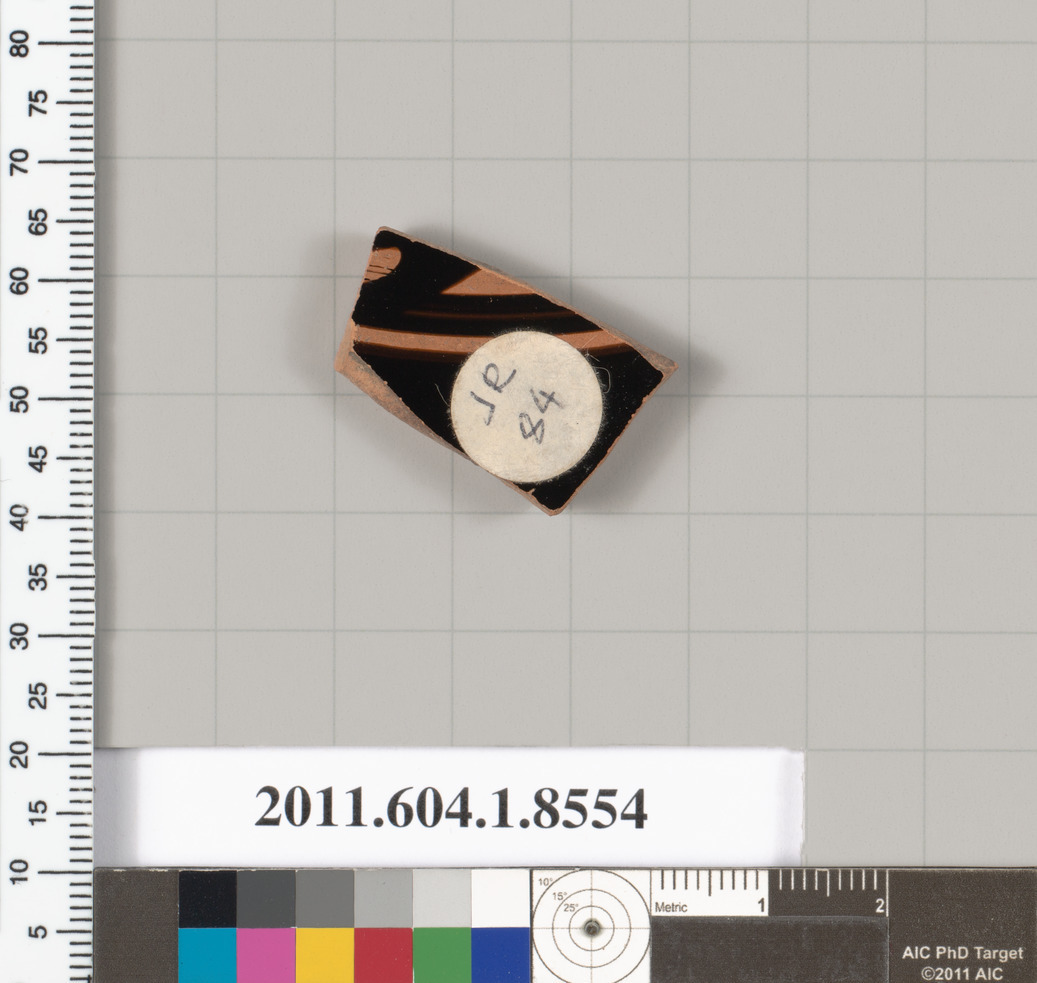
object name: kylix fragment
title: Terracotta fragment of a stemless kylix (drinking cup)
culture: greek, attic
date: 460-450 BCE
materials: terracotta